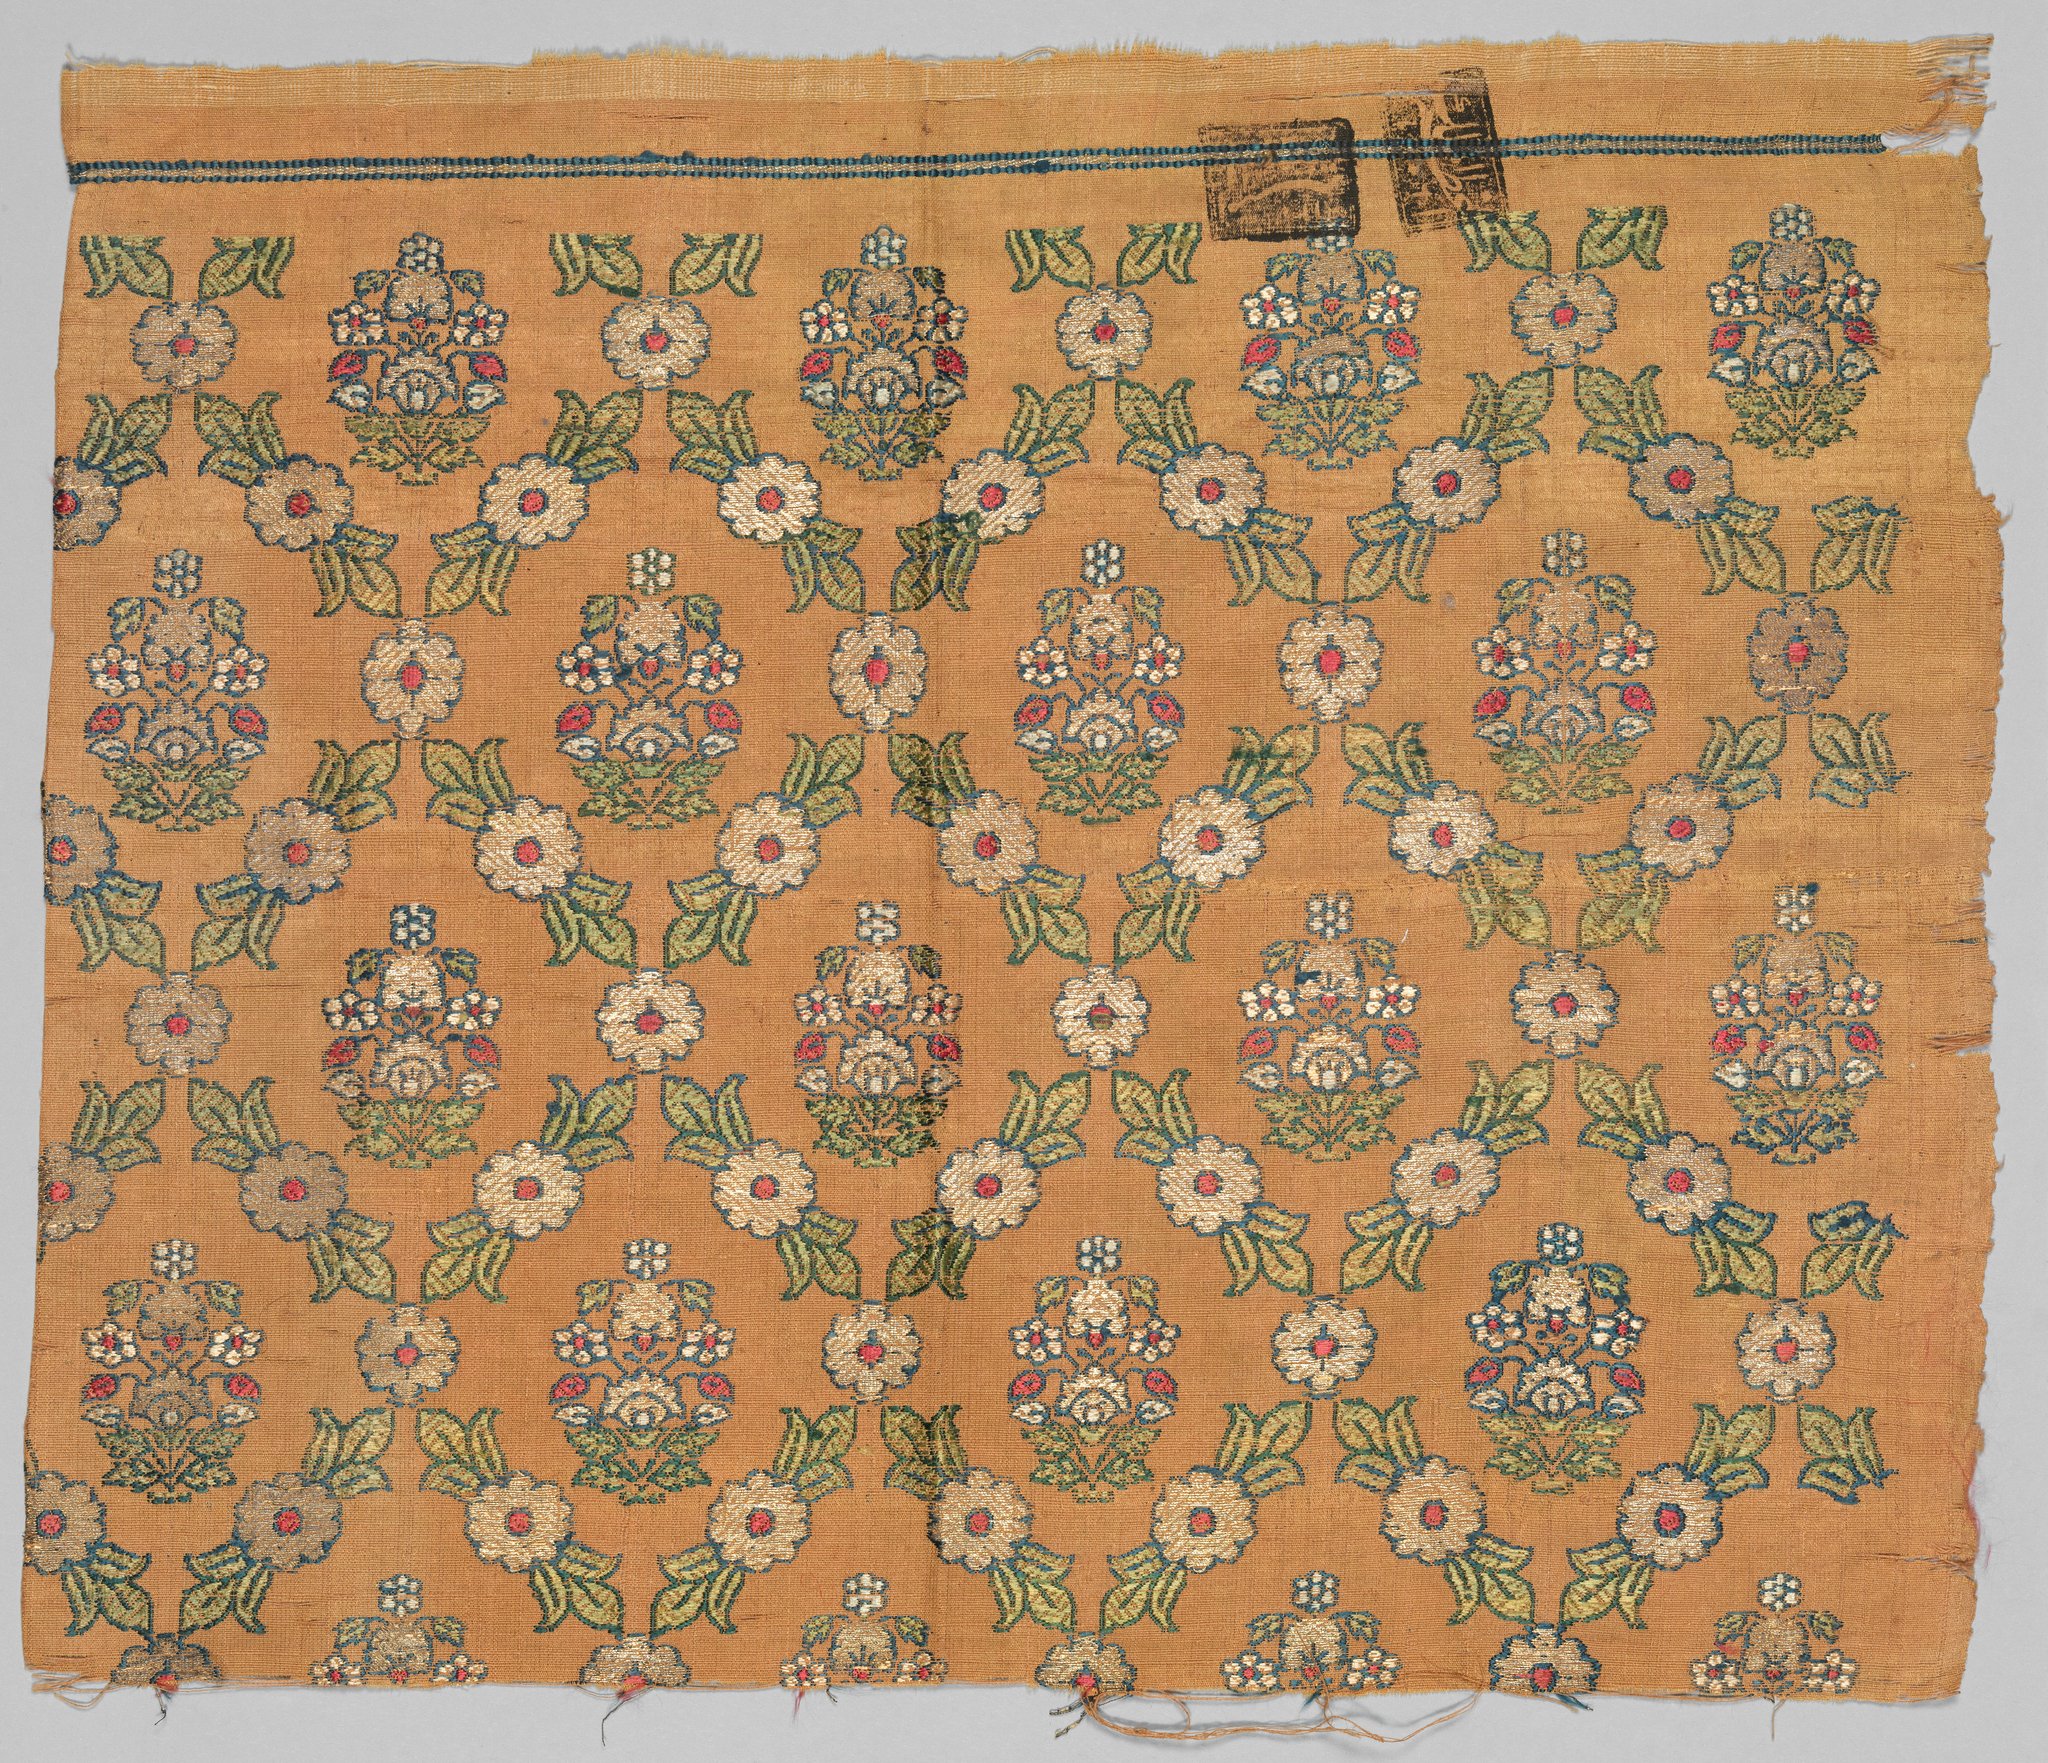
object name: textile fragment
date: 1801-1900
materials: metal thread, silk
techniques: brocade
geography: india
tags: flowers